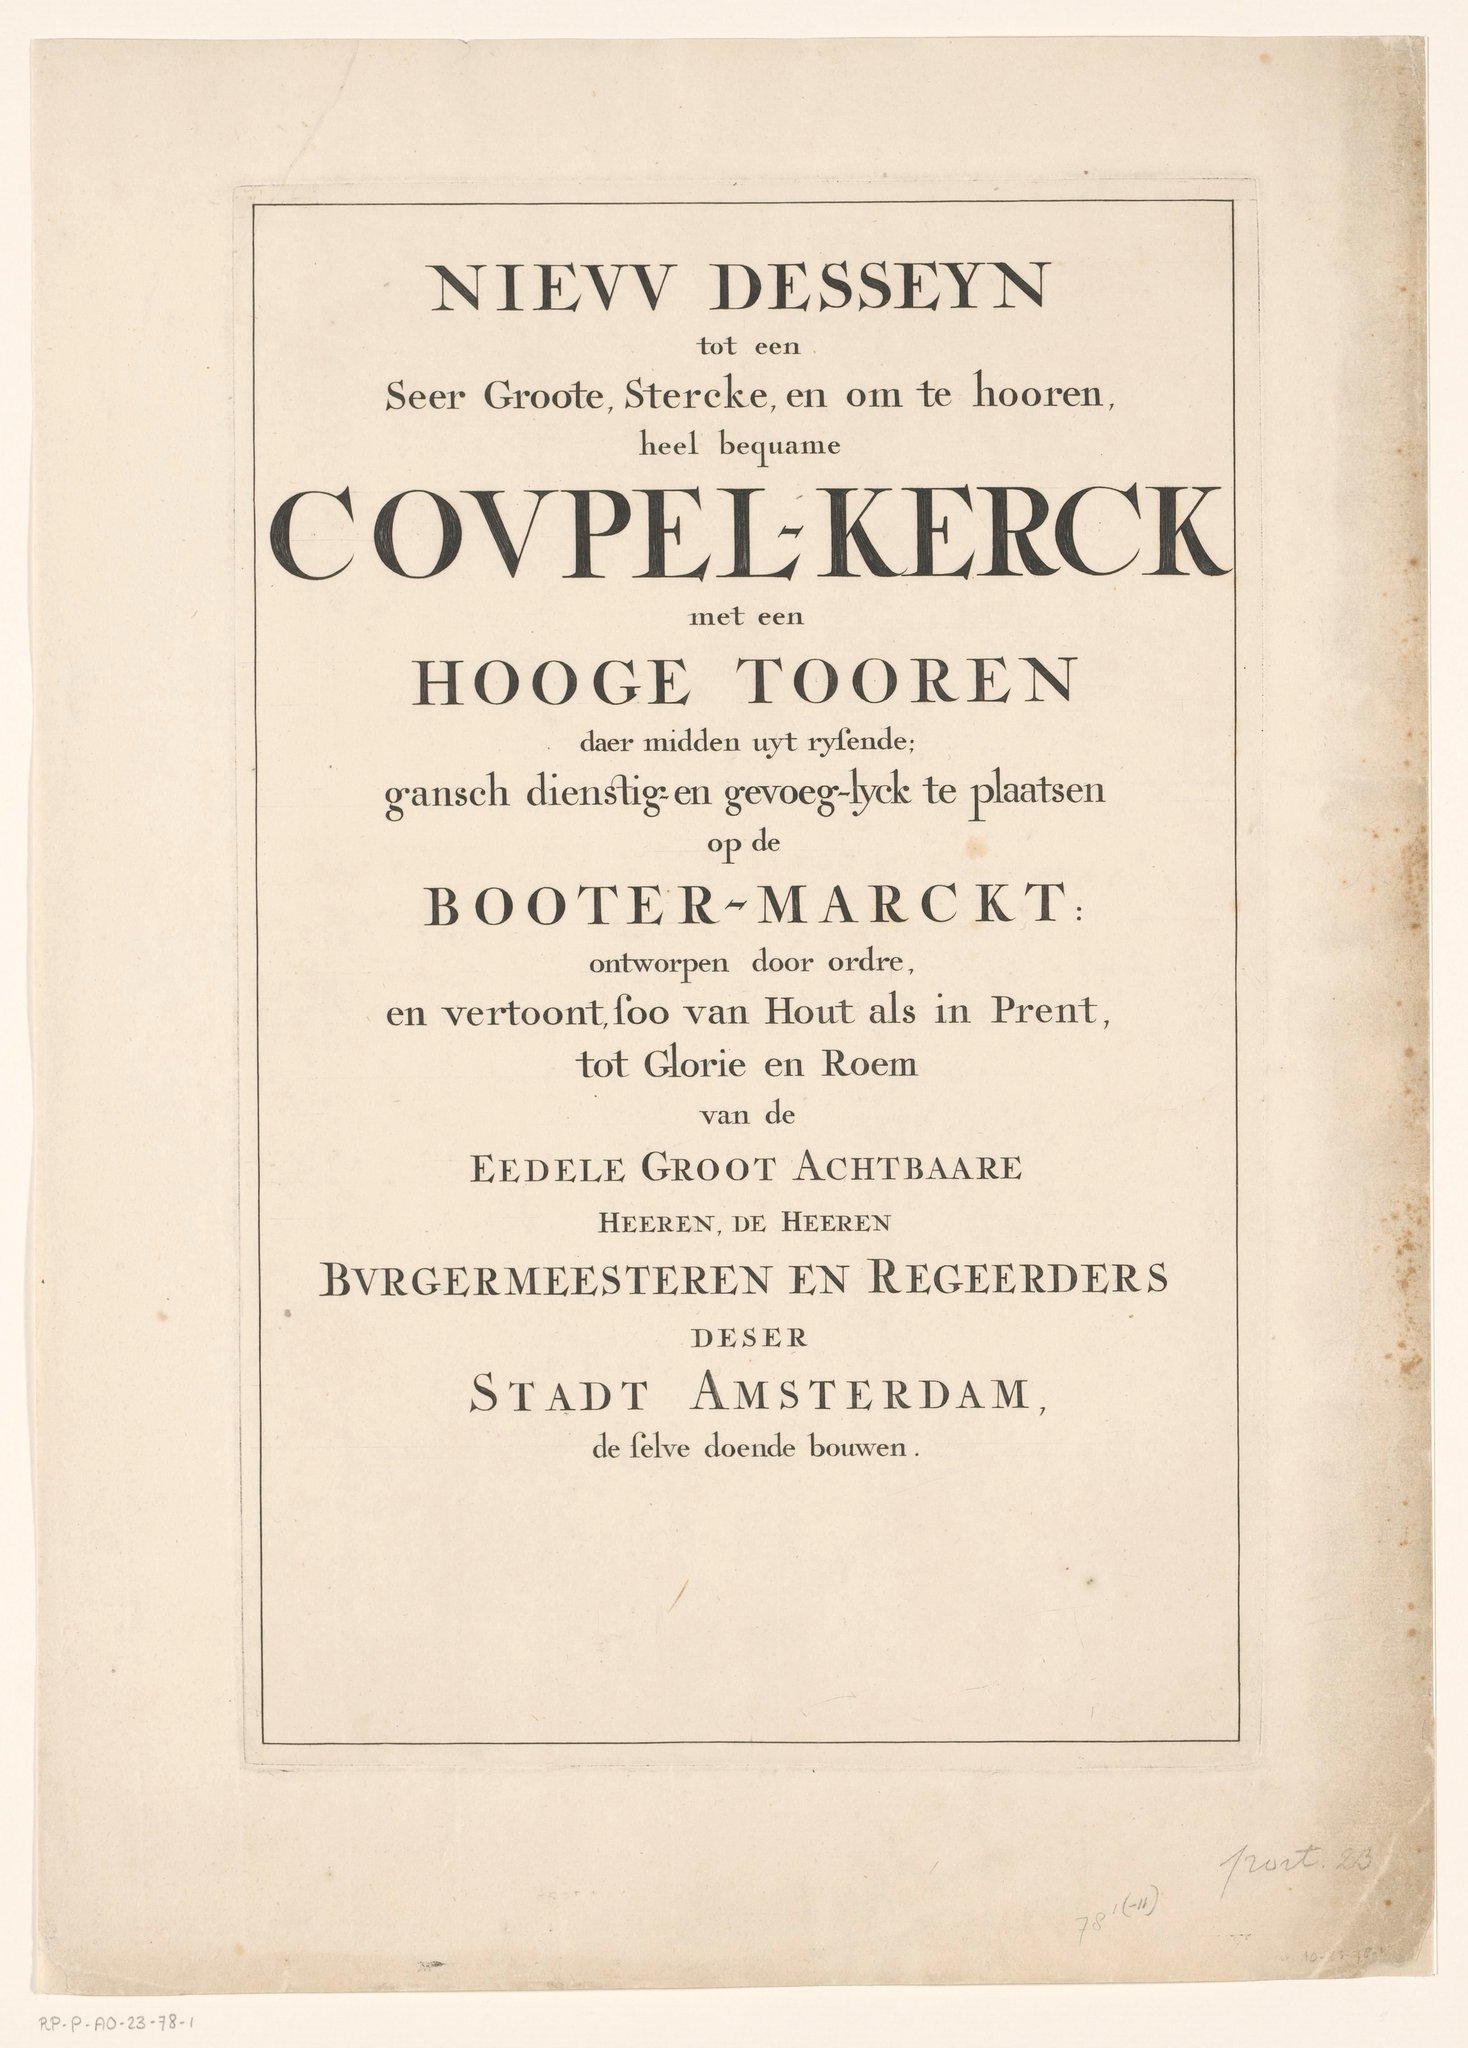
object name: titelprent, frontispice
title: Nievv desseyn tot een Seer Groote, Stercke, en om te hooren, heel bequame Coupel-Kerck met een Hooge Tooren daer midden uyt rysende; gansch dienstig- en gevoeg-lyck te plaatsen op de Booter-Marckt: ontworpen door ordre, en vertoont, soo van Hout als in Prent, tot Glorie en Roem van de Eedele Groot Achtbaare Heeren, de Heeren Burgermeesteren en Regeerders deser Stadt Amsterdam, de selve doende bouwen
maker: daniël stopendaal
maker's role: print maker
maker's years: 1672-1726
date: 1700-1705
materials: paper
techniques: engraving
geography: amsterdam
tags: title-page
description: Notaris, advocaat en kerkmeester van de Oude Kerk Nicolaas Listingh maakte rond 1700 een ontwerp voor een nieuwe koepelkerk op de Botermarkt (het huidige Rembrandtplein). Naast een houten maquette, die nog steeds te zien is in de Oude Kerk, liet hij ook op eigen kosten een serie van zeventien prenten van zijn ontwerp maken ('Nievv desseyn tot een Seer Groote, Stercke, en om te hooren, heel bequame Coupel-Kerck (…)'). De huidige prent is daar onderdeel van. Deze prenten zouden zijn gemaakt door Daniël Stopendaal.* *Long, Isaac le. Historische beschryvinge van de reformatie der stadt Amsterdam (…). Amsterdam: Johannes van Septeren (I), 1729, p. 572.